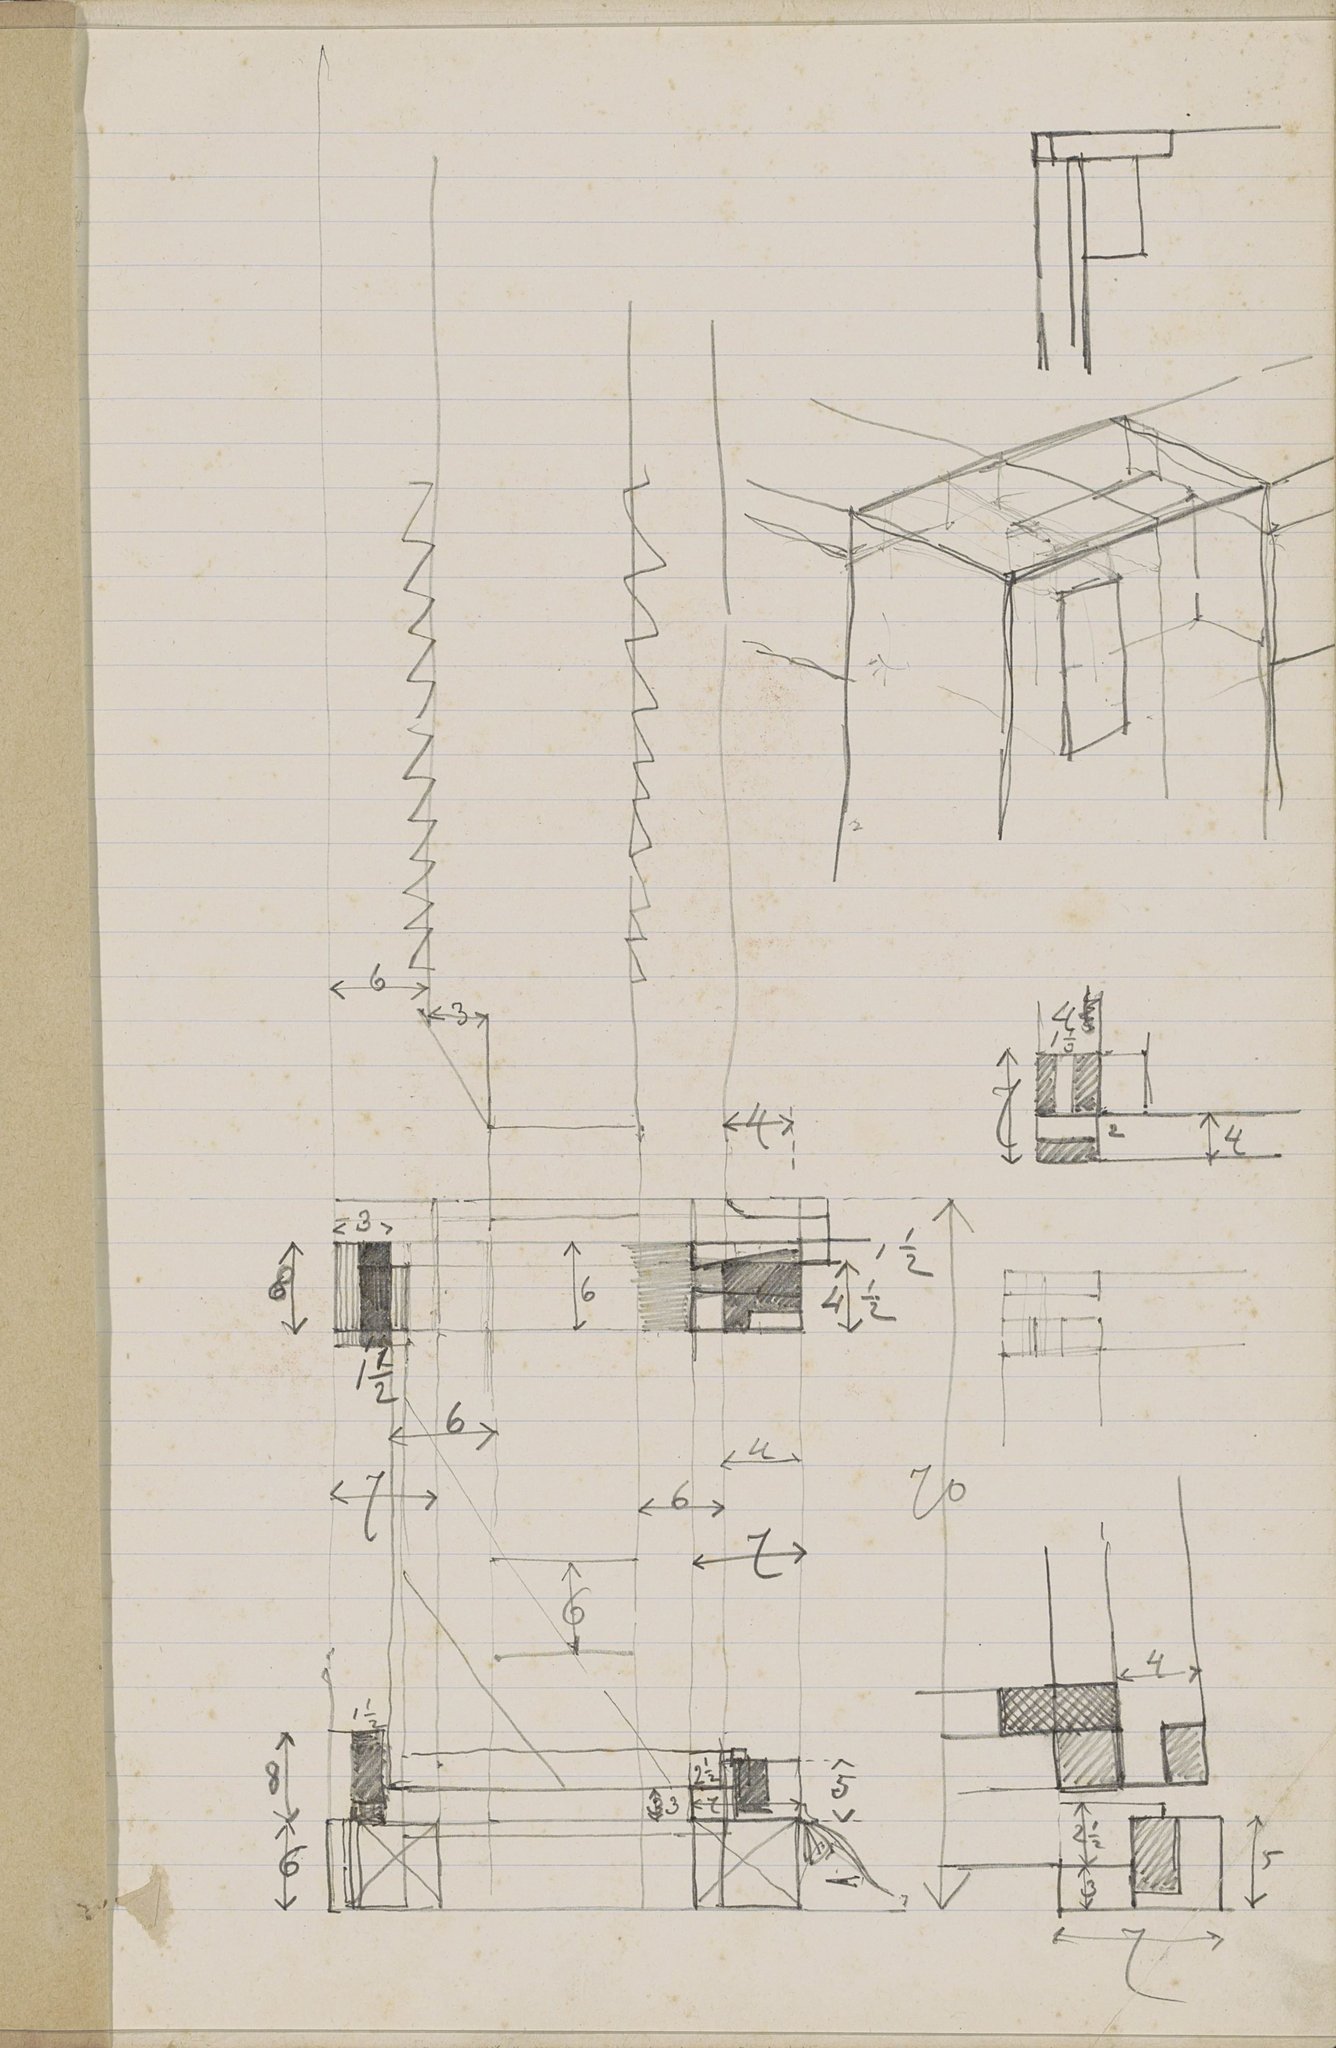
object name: sketchbook leaf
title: Meubelontwerp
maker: gerrit willem dijsselhof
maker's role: designer, draughtsman, print maker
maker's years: 1866-1924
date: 1901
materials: pencil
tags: design, plan (~ production), flowers ~ ornament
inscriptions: annotation: ‘[...]’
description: Blad 2 recto uit een schetsboek met 79 bladen.